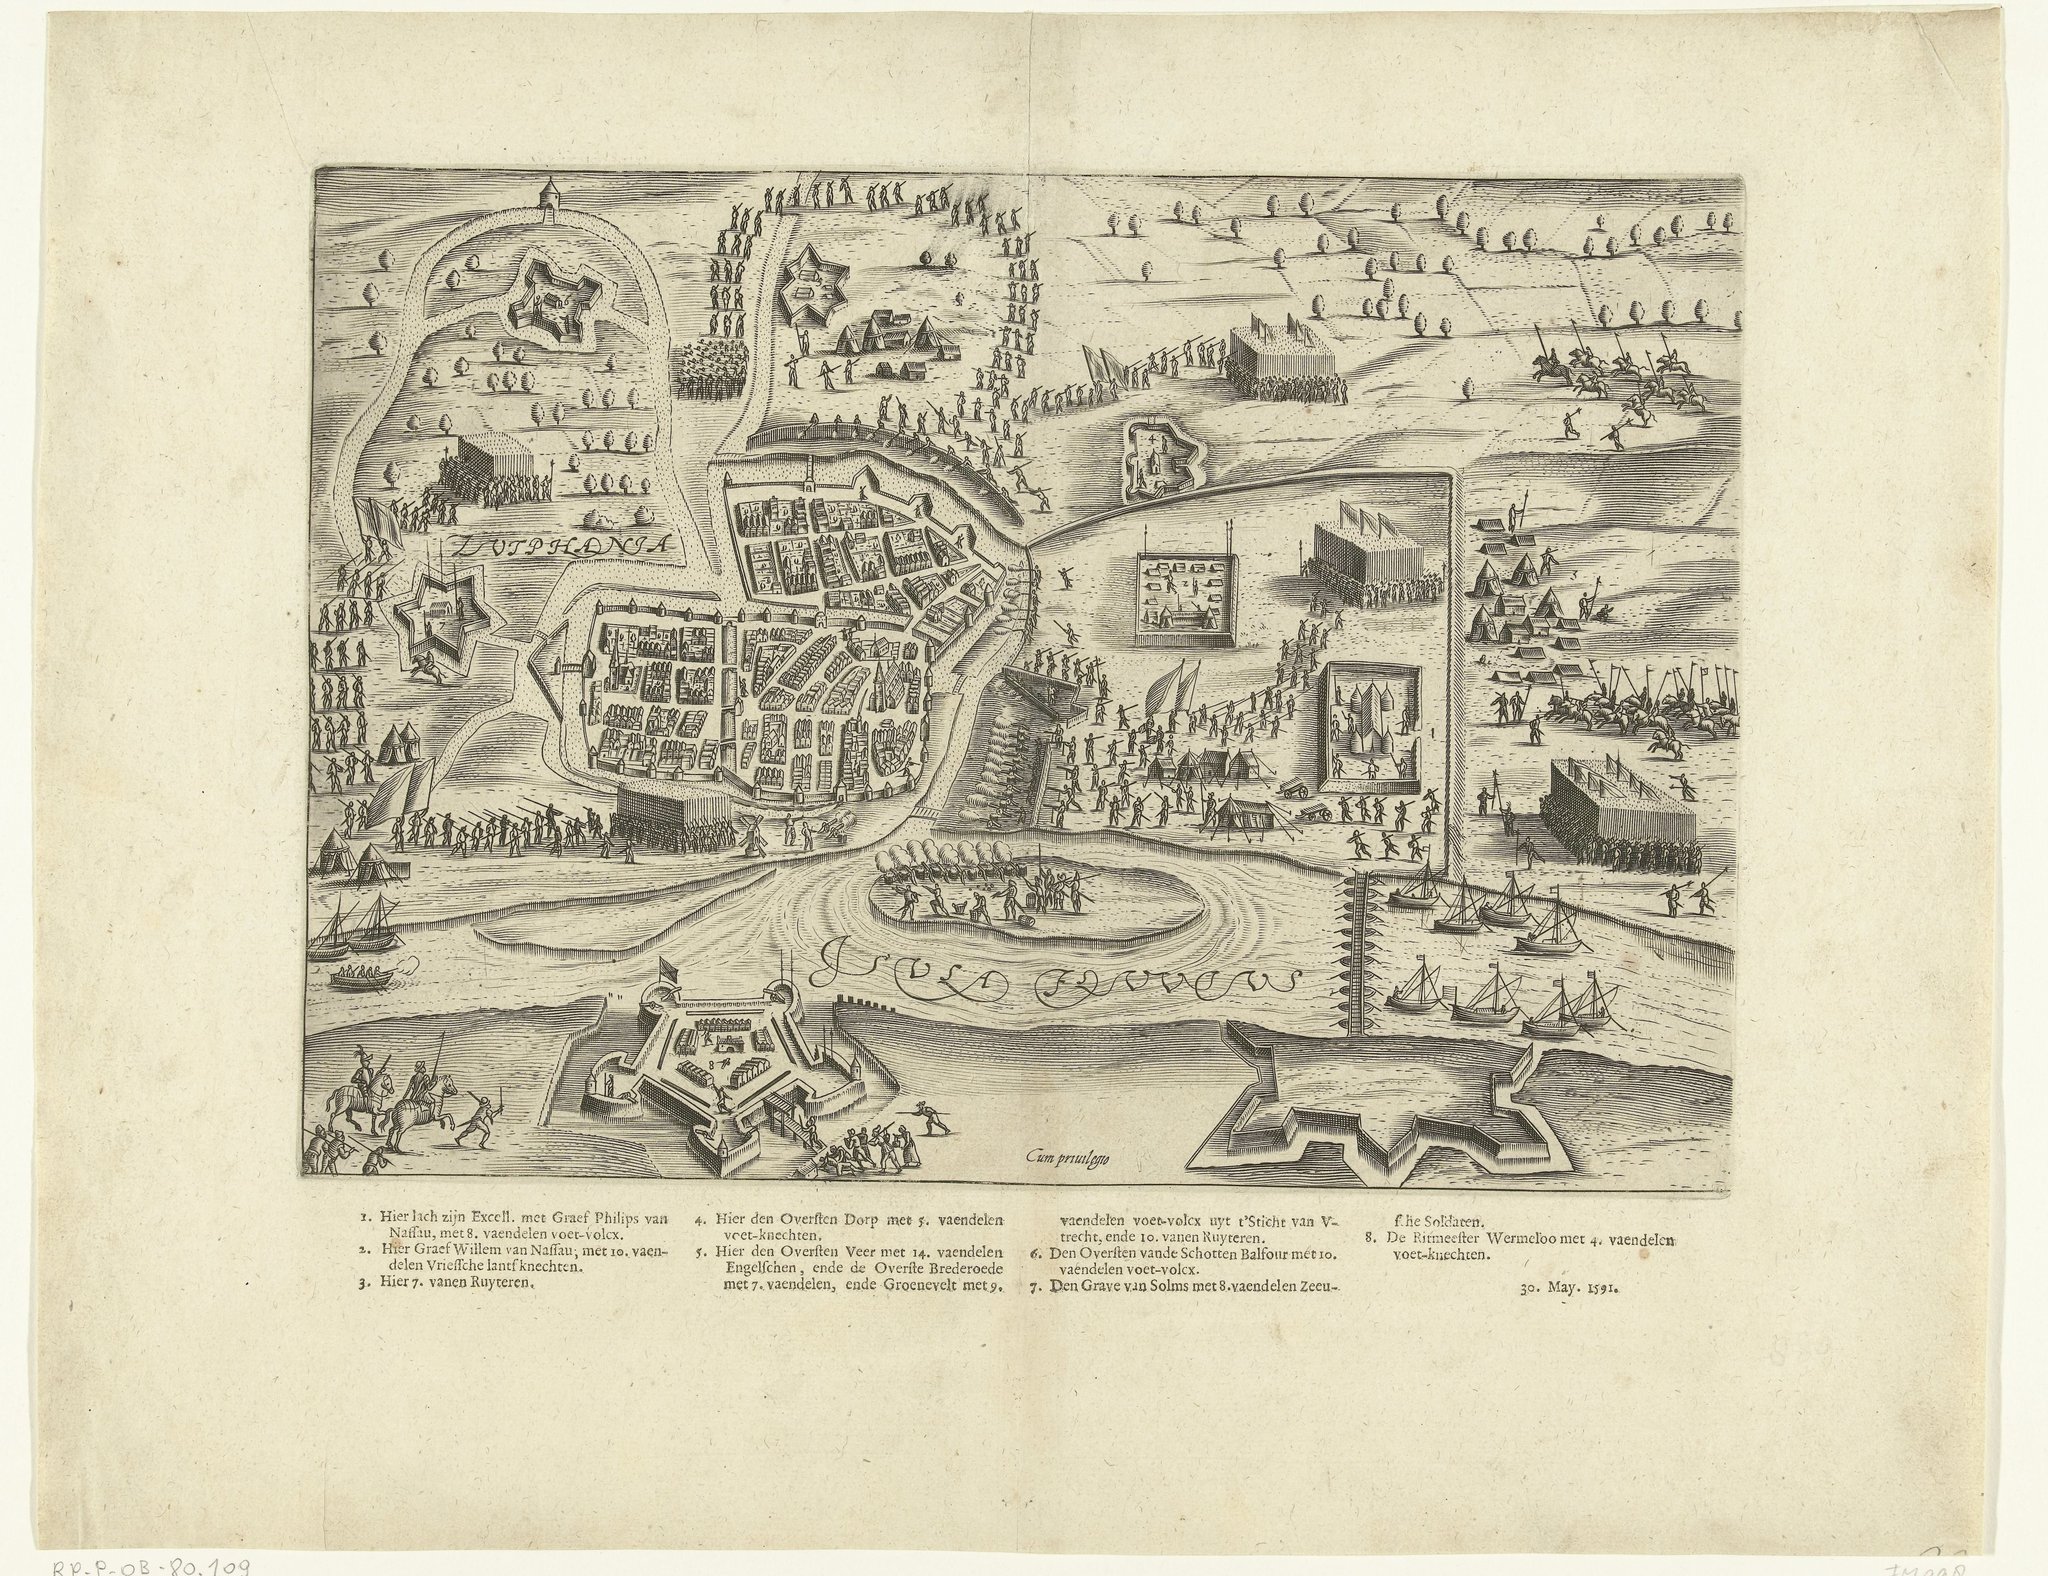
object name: print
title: Inname van Zutphen, 1591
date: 1600-1601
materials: paper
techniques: engraving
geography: northern netherlands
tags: capture of city (after the siege)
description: Gebruikt als illustratie in: J.J. Orlers, Den Nassauschen Lauren-Crans: Beschrijvinghe ende af-beeldinge van alle de victorien ... die Godt Almachtich de ... Staten der Vereenichde Nederlanden verleent heeft, deur het wijs ende clouck beleyt des Hooch-ghebooren Fursts Maurits van Nassau, J.J. Orlers en H. van Haestens, Leiden 1610, fol. 78/79.